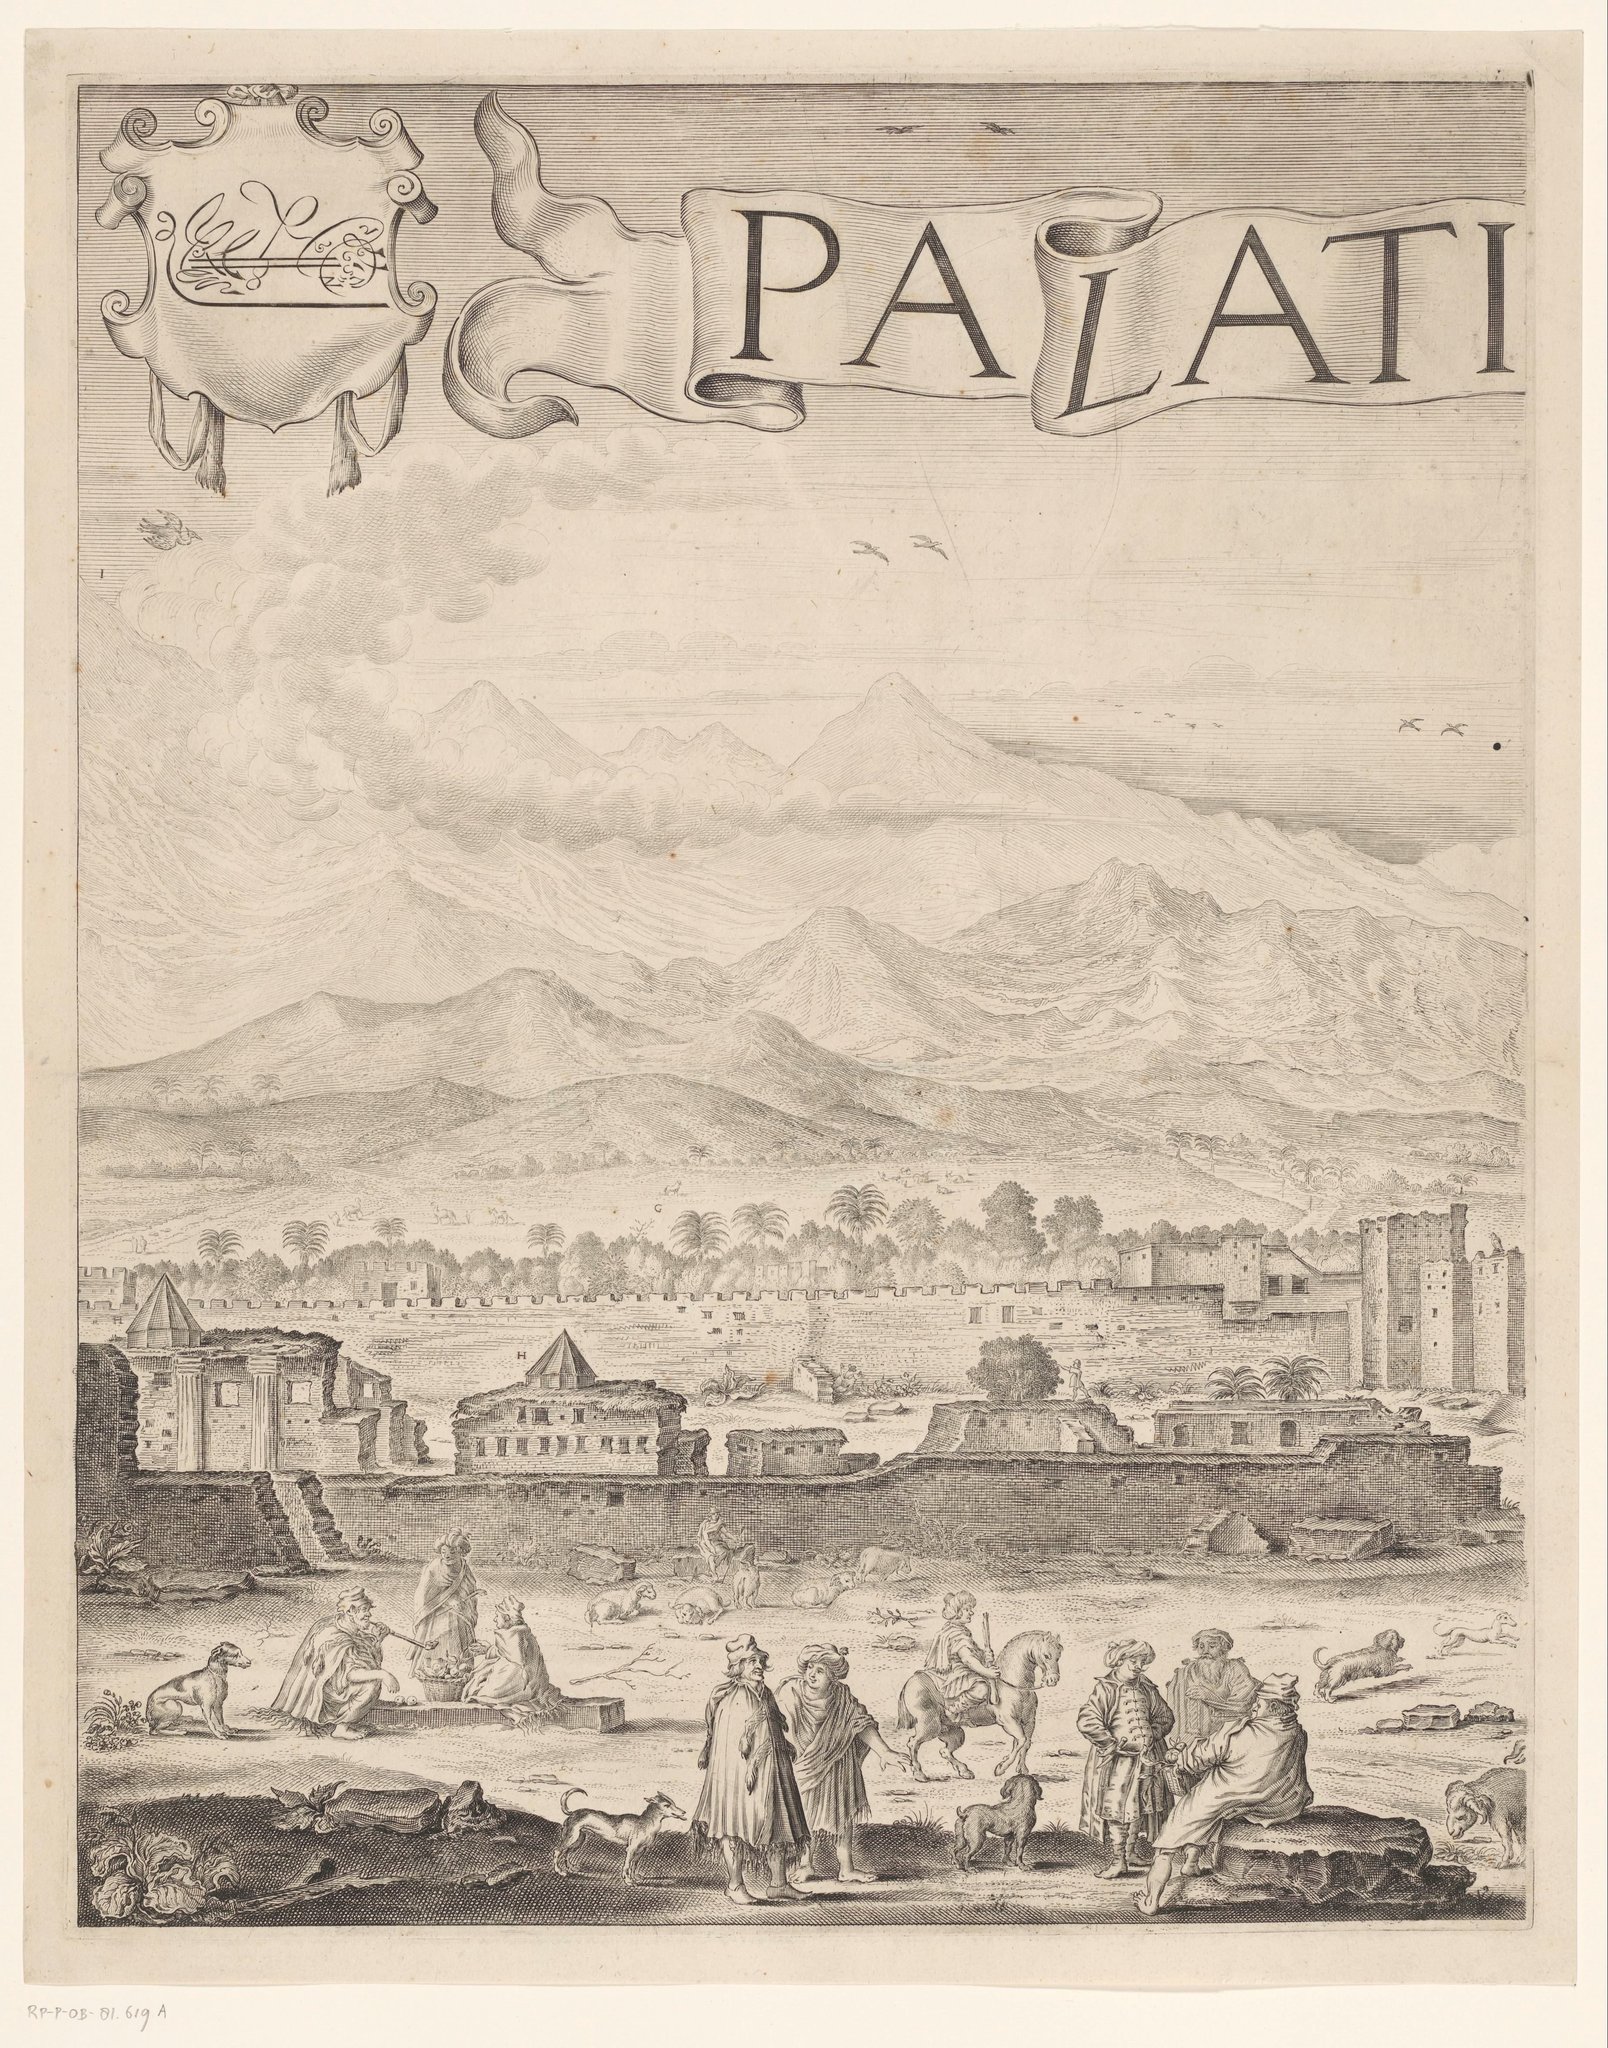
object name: print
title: Het paleis van de sultan van Marokko (plaat 1), 1640-1641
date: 1646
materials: paper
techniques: engraving, etching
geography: the hague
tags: palace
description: Gezicht op het paleis van de sultan van Marokko in Marrakesh, ten tijde van het bezoek door het gezantschap op een handelsmissie namens de Staten-Generaal onder leiding van Antonius de Liedekercke, van november 1640 tot april 1641. Het paleis (waarschijnlijk het paleis El-Badi) van de sultan Mohammed esh Sheikh es Seghir (op de prent aangeduid als Muley Hamet). Eerste plaat in een ongemonteerd ensemble bestaande uit vijf prenten en 4 tekstbladen. Bovenaan een cartouche met een Arabische opschrift en een banderol met een deel van de titel; op de voorgrond leden van de lokale bevolking.